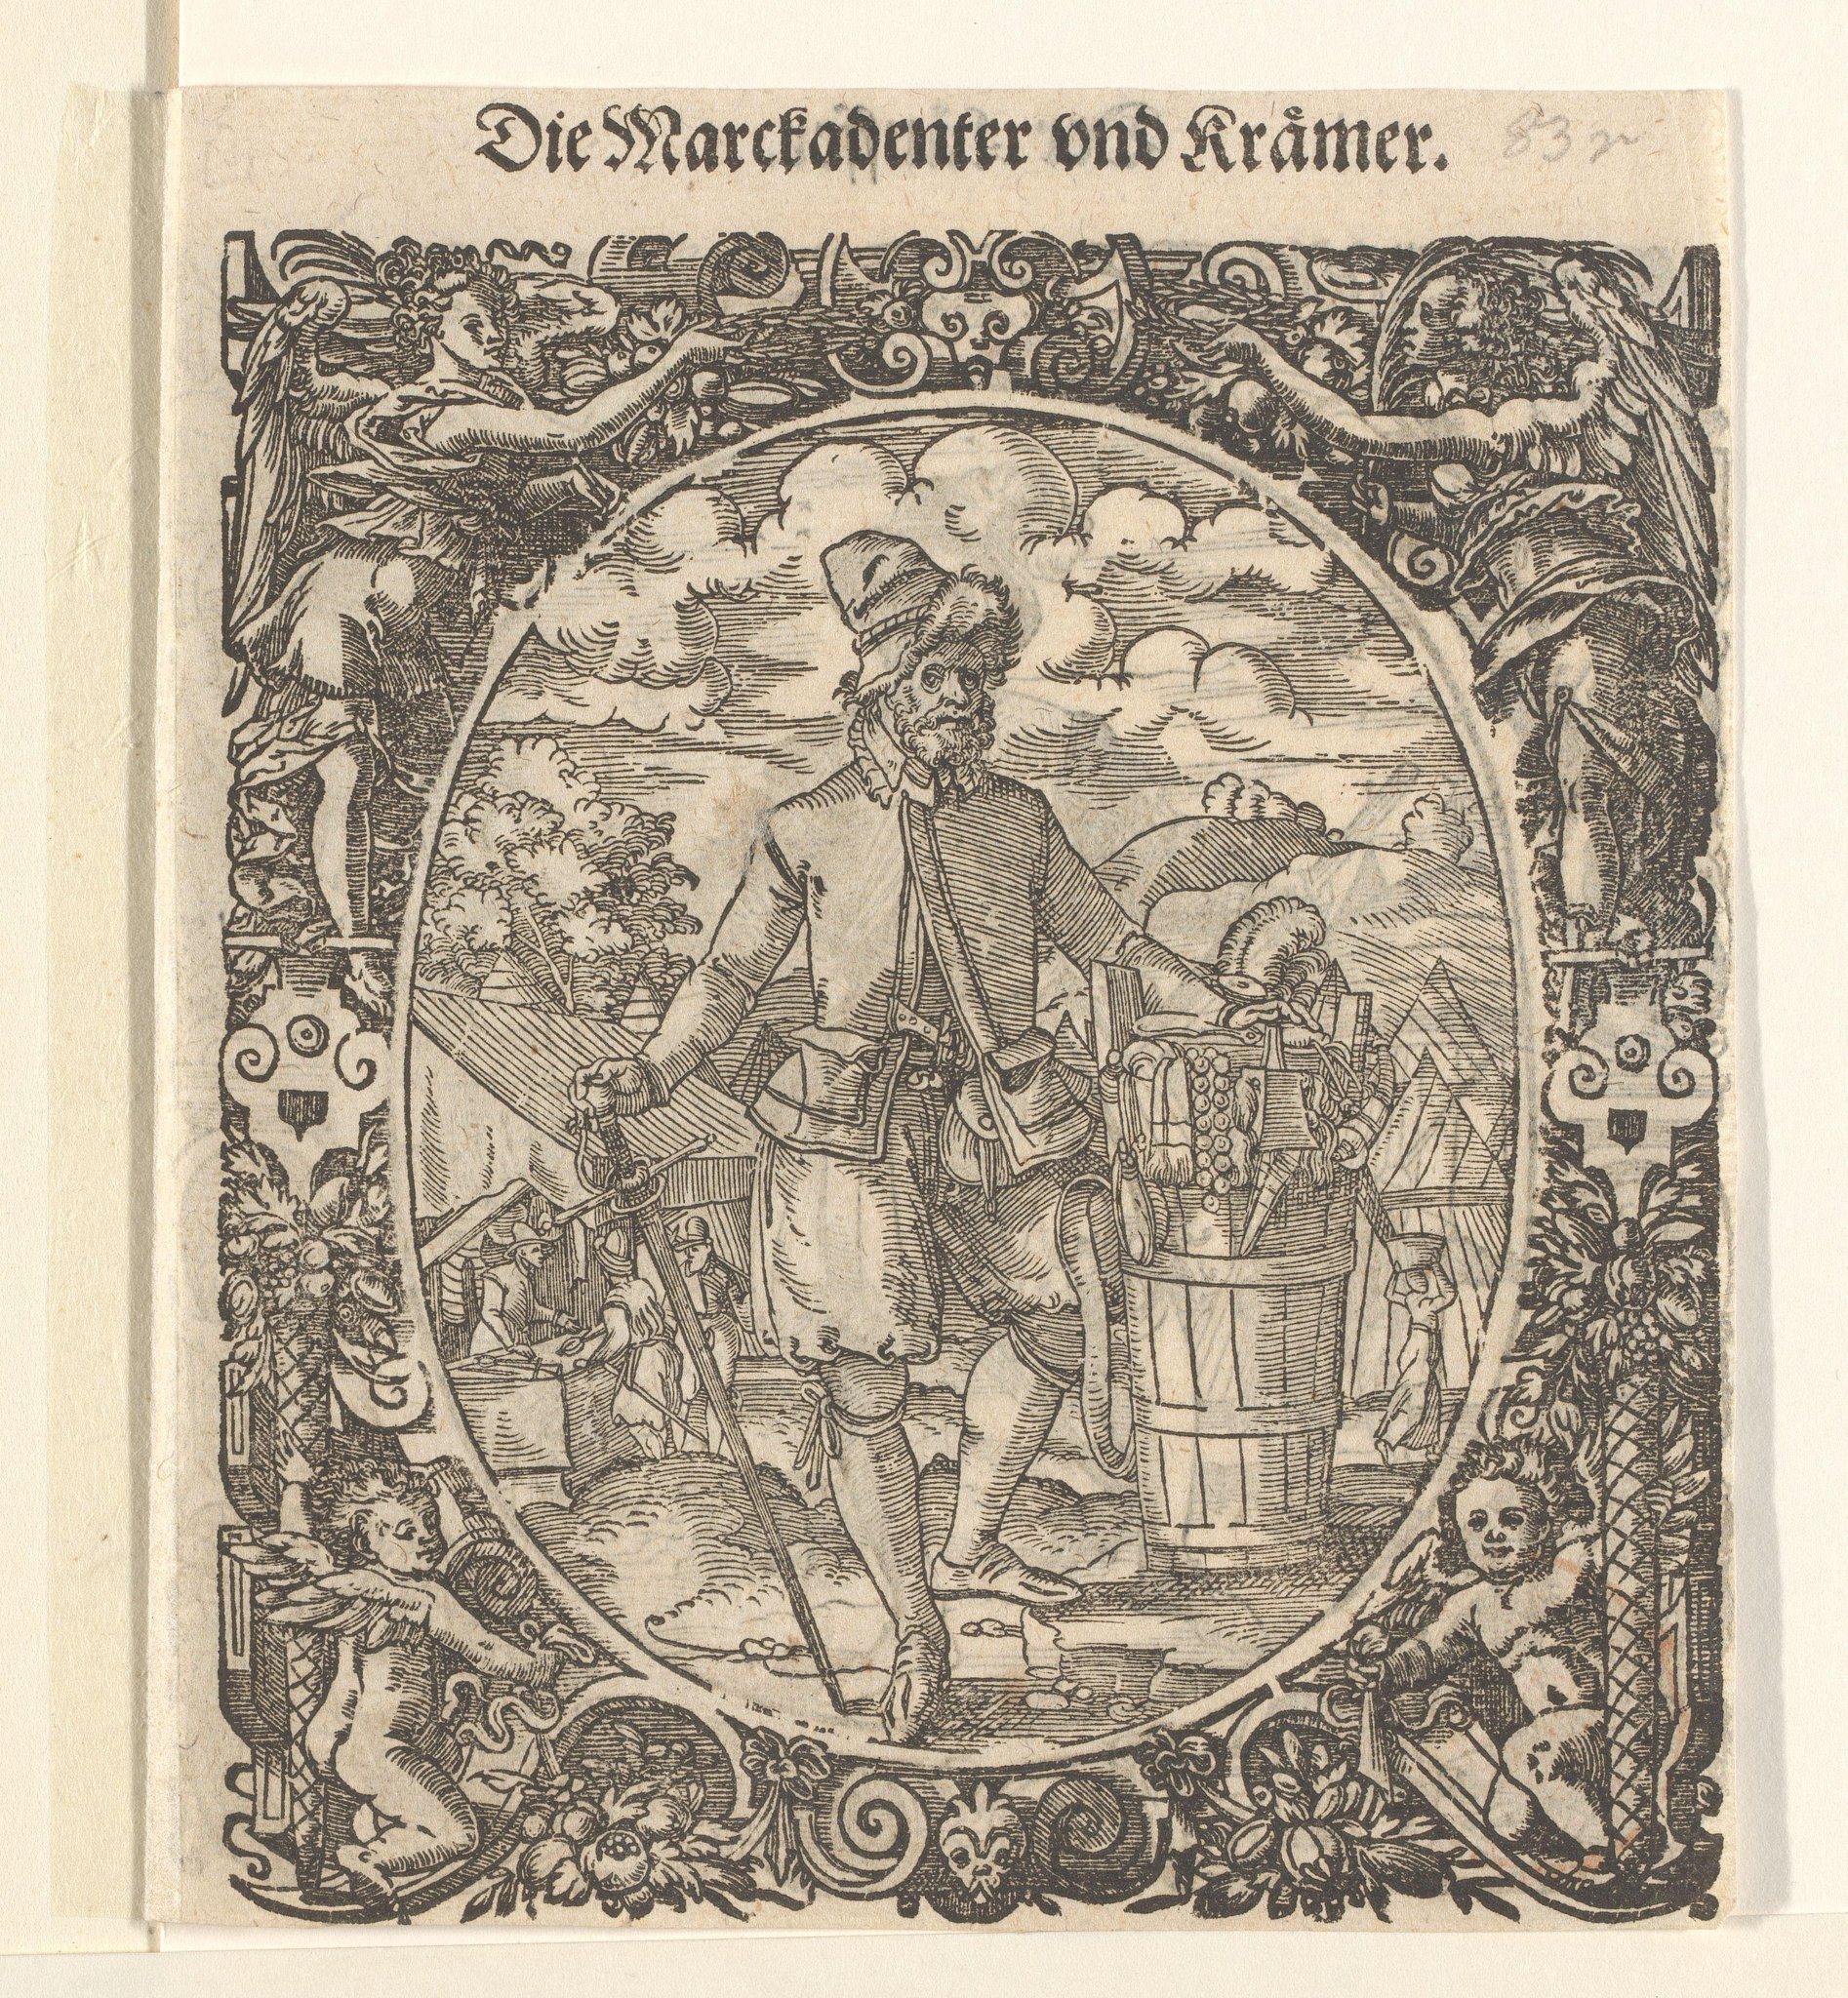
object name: book illustration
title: Die Marcktadenter und Krämer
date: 1573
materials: paper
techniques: woodcut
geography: nuremberg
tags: pedlar, warfare; military affairs, the soldier; the soldier's life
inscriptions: collector's mark: Lugt 240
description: Zowel de voorstelling als de ornamentrand werd gebruikt voor verschillende edities van Leonhardt Fronspergers Kriegsbuch.